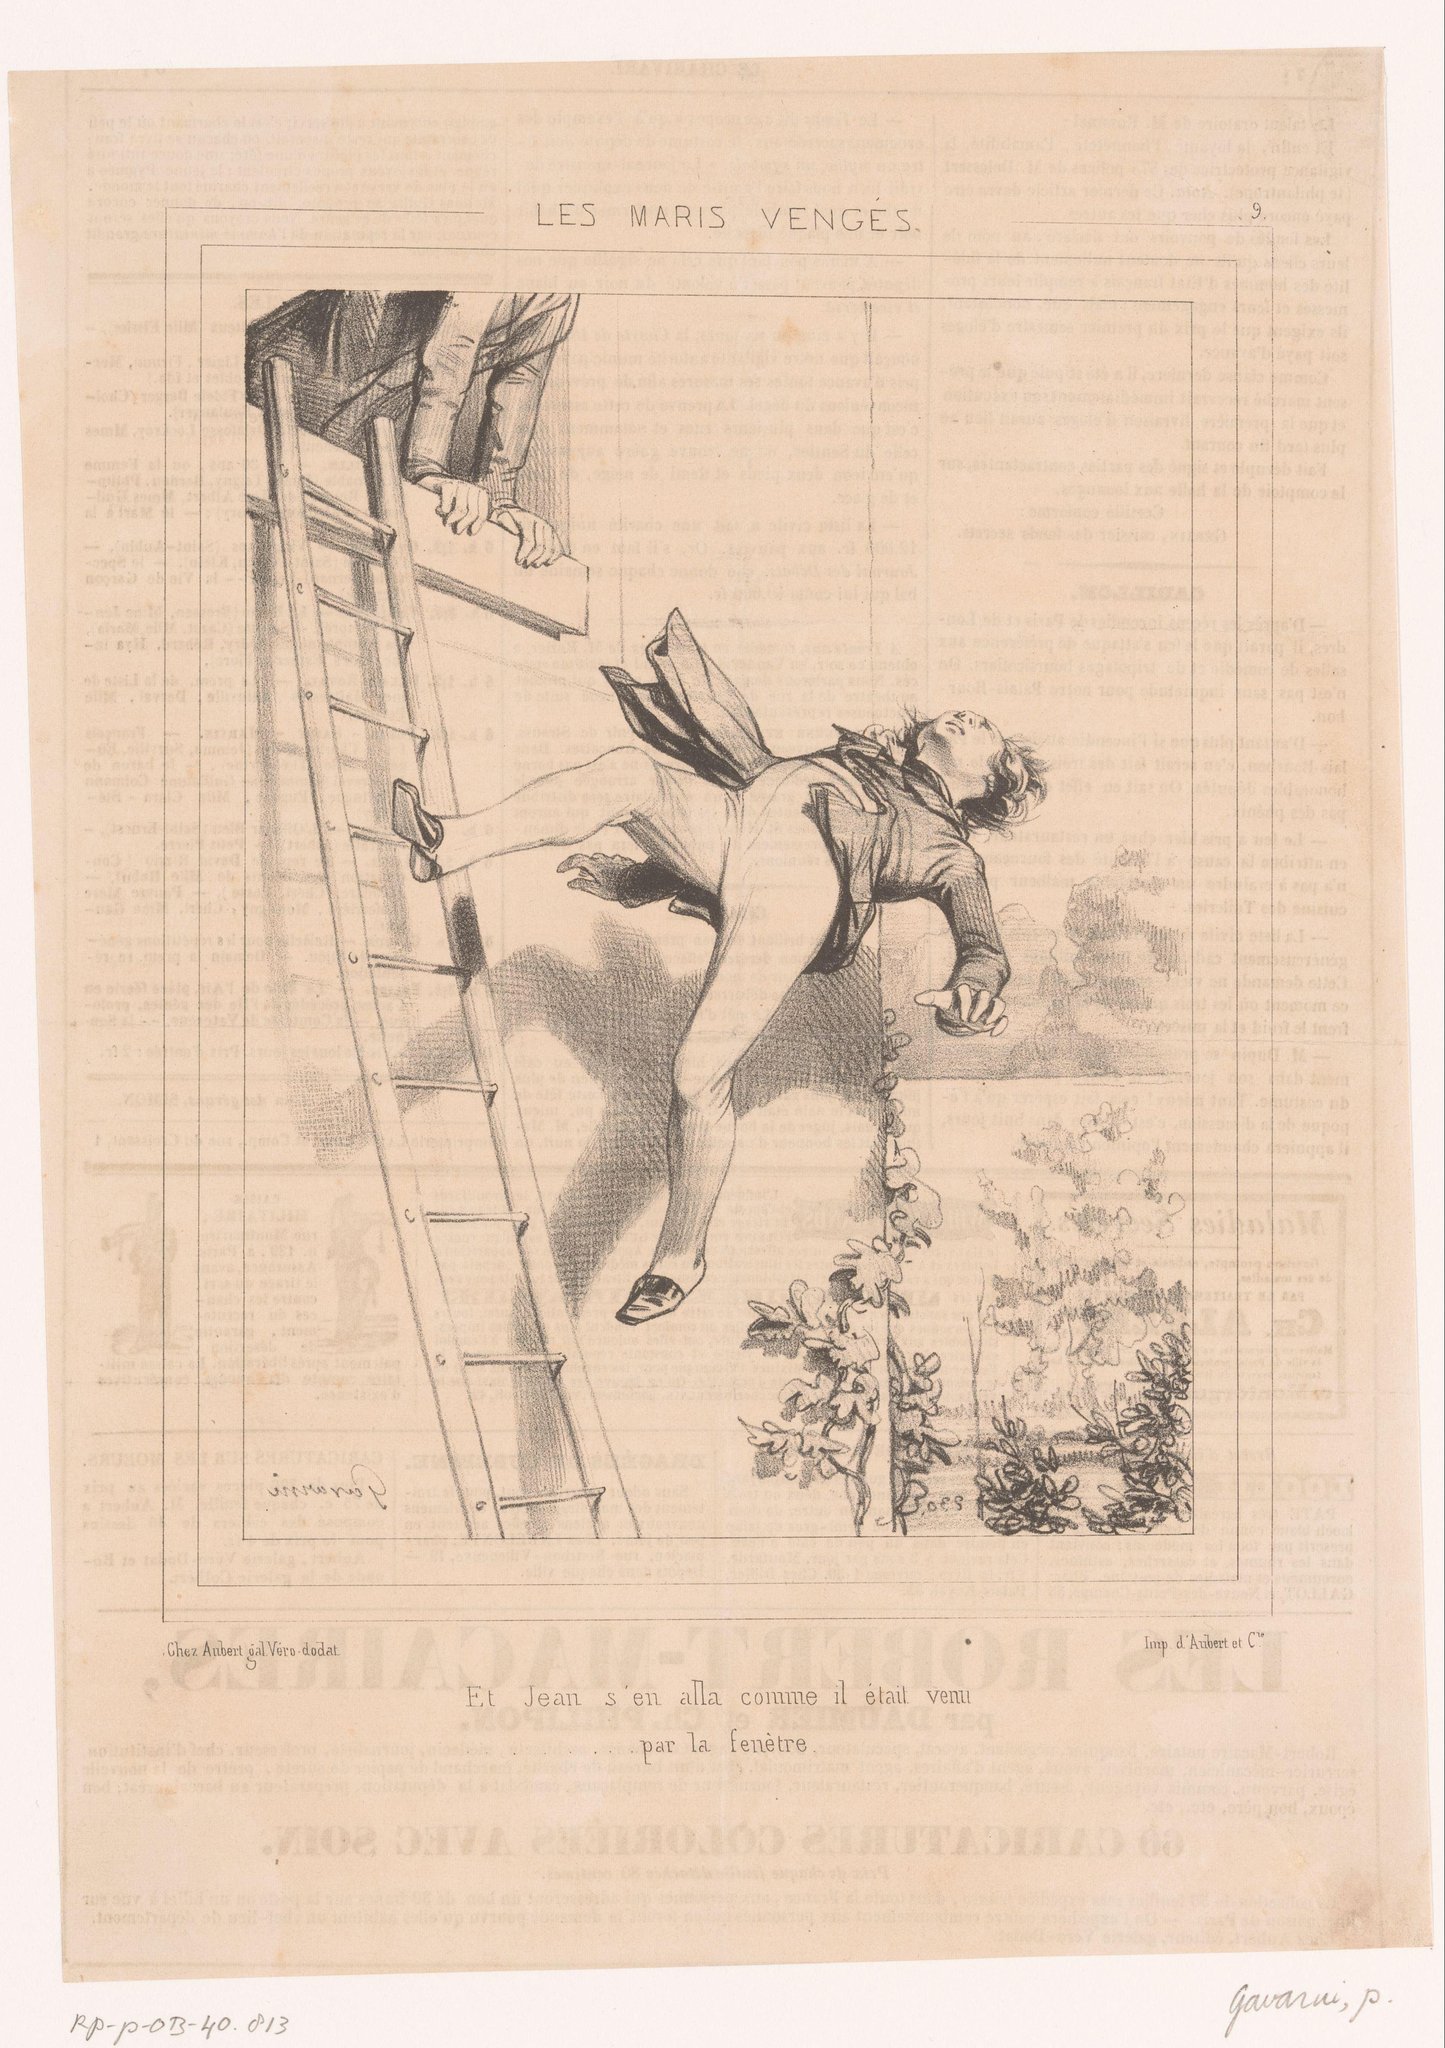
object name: print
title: Gewroken echtgenoten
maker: paul gavarni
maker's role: draughtsman, print maker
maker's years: 1804-1866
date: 1838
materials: paper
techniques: lithograph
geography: paris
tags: falling through the air, falling, ladder, open window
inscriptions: collector's mark: Lugt 2228a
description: Prent gebruikt voor: Le Charivari, 26 januari 1838.